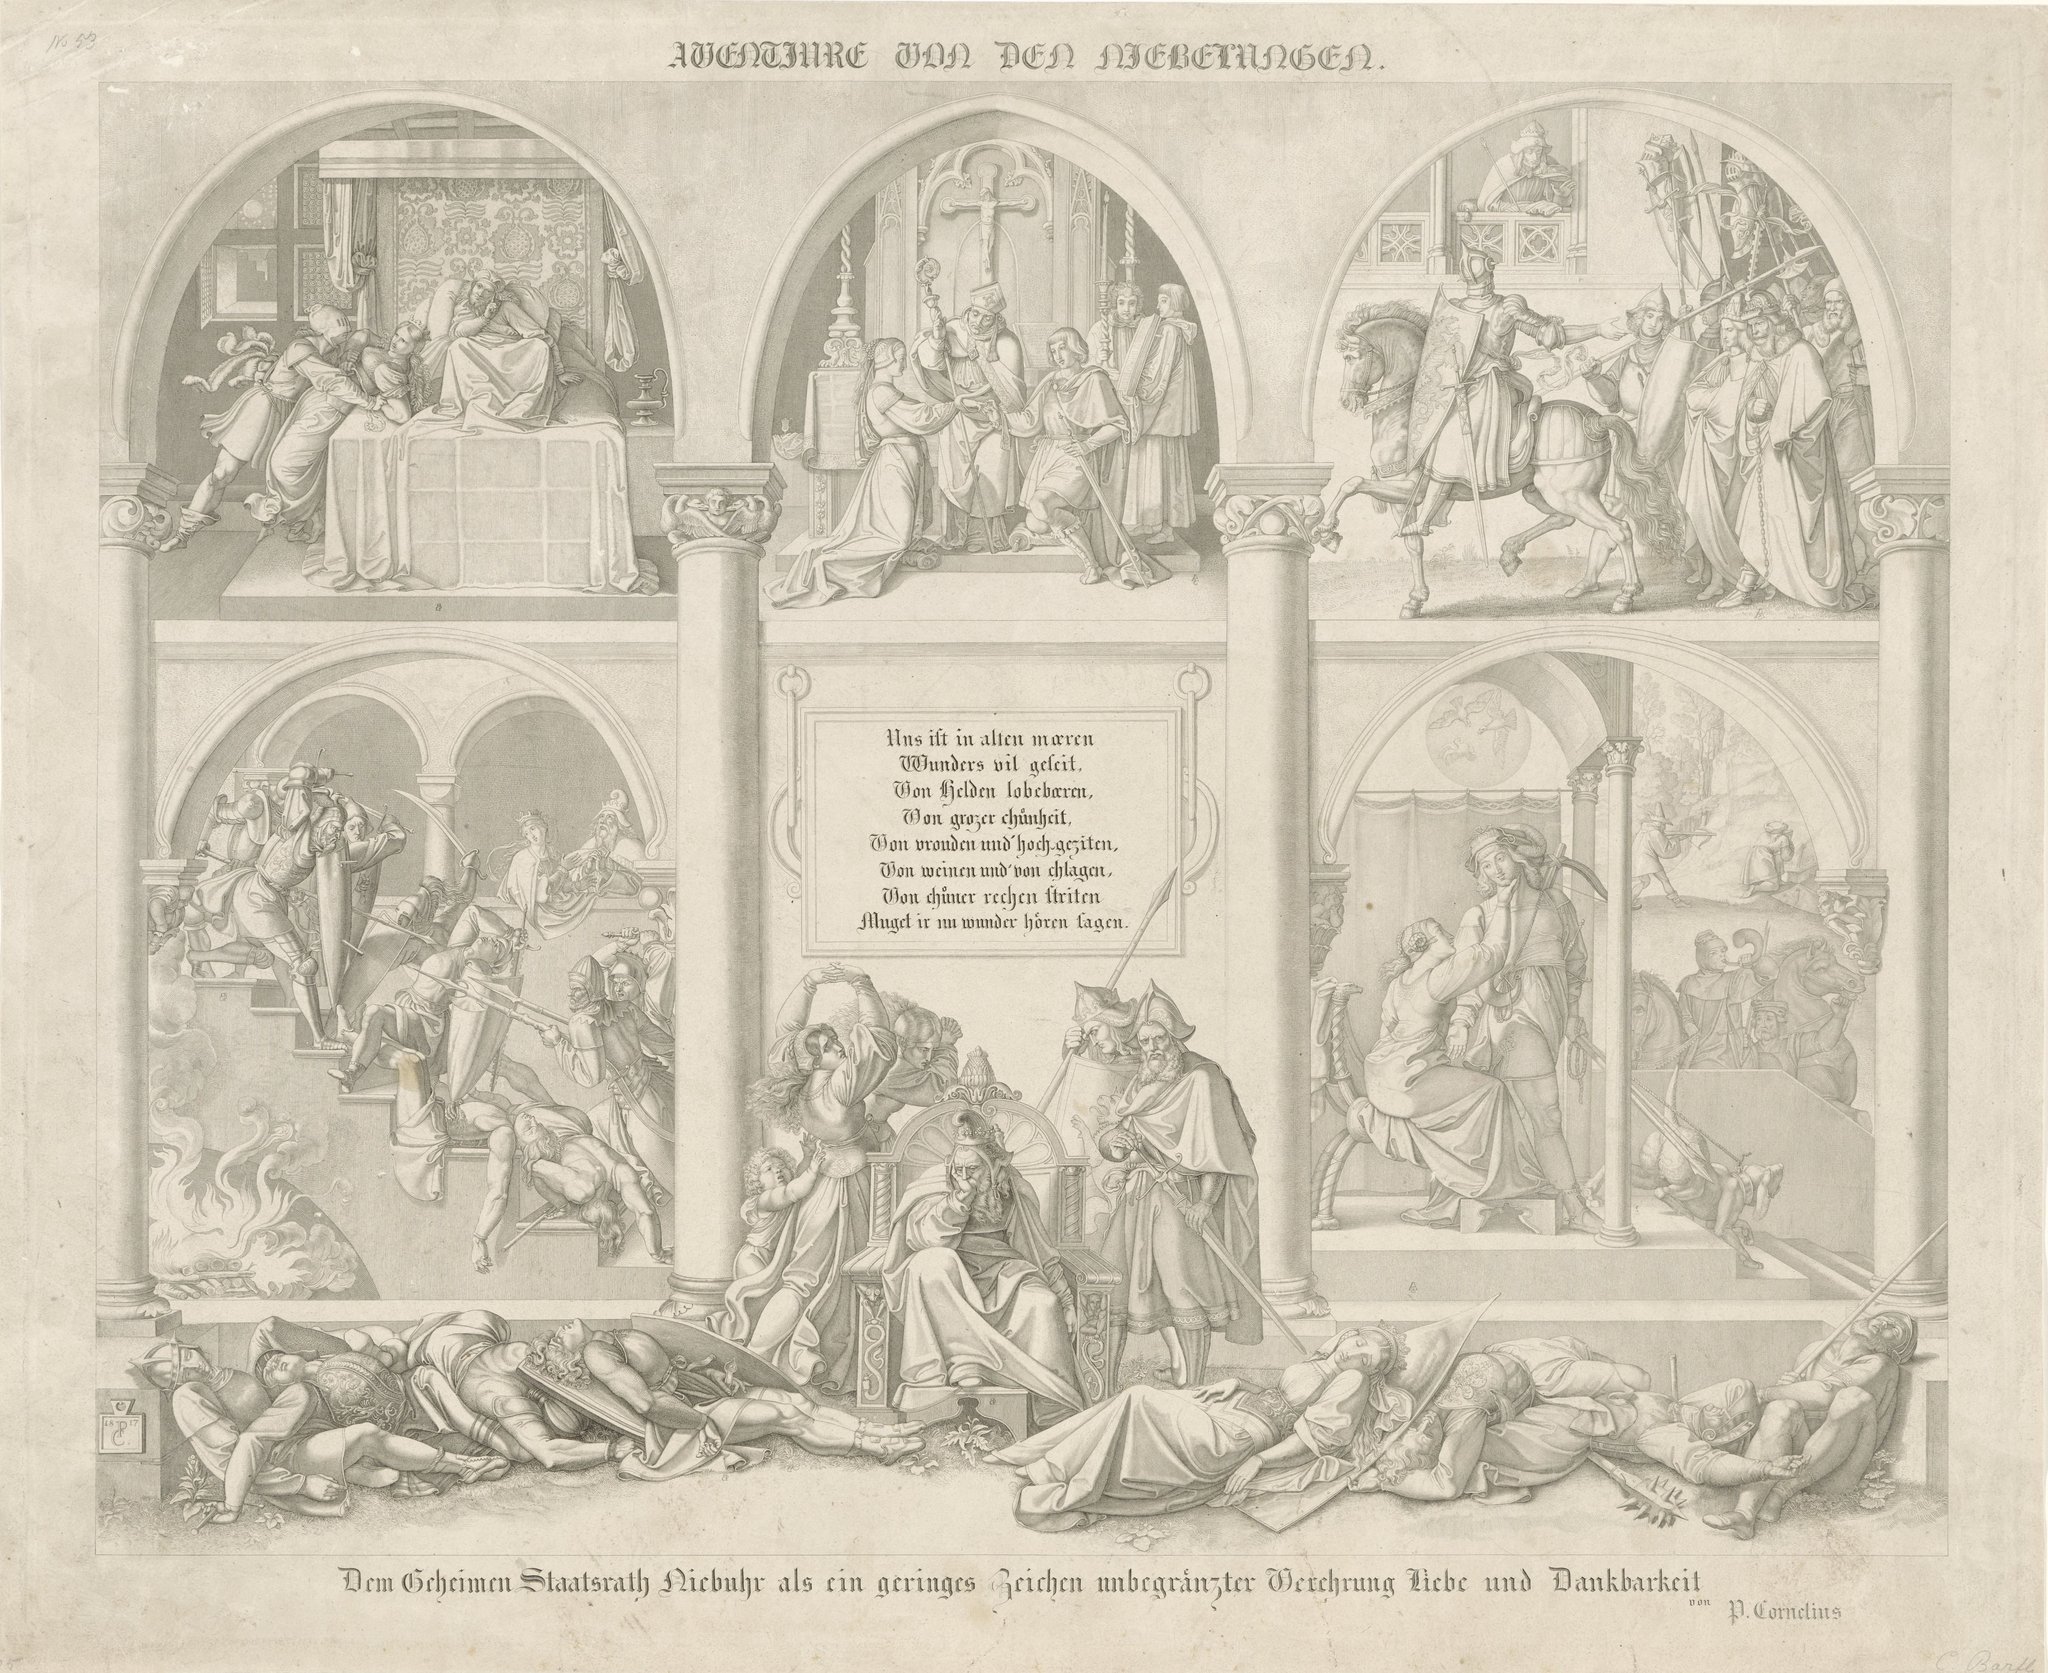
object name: titelprent, frontispice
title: Aventiure von den Nibelungen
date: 1817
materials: paper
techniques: etching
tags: riding a horse, ass, or mule; rider, horseman, archbishop, bishop, etc. (roman catholic), 'nibelungenlied', bed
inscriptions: collector's mark: Lugt 2228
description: Doorkijk van een met zuilen en bogen omgeven ruimte naar zes scenes van de Nibelungensagen.